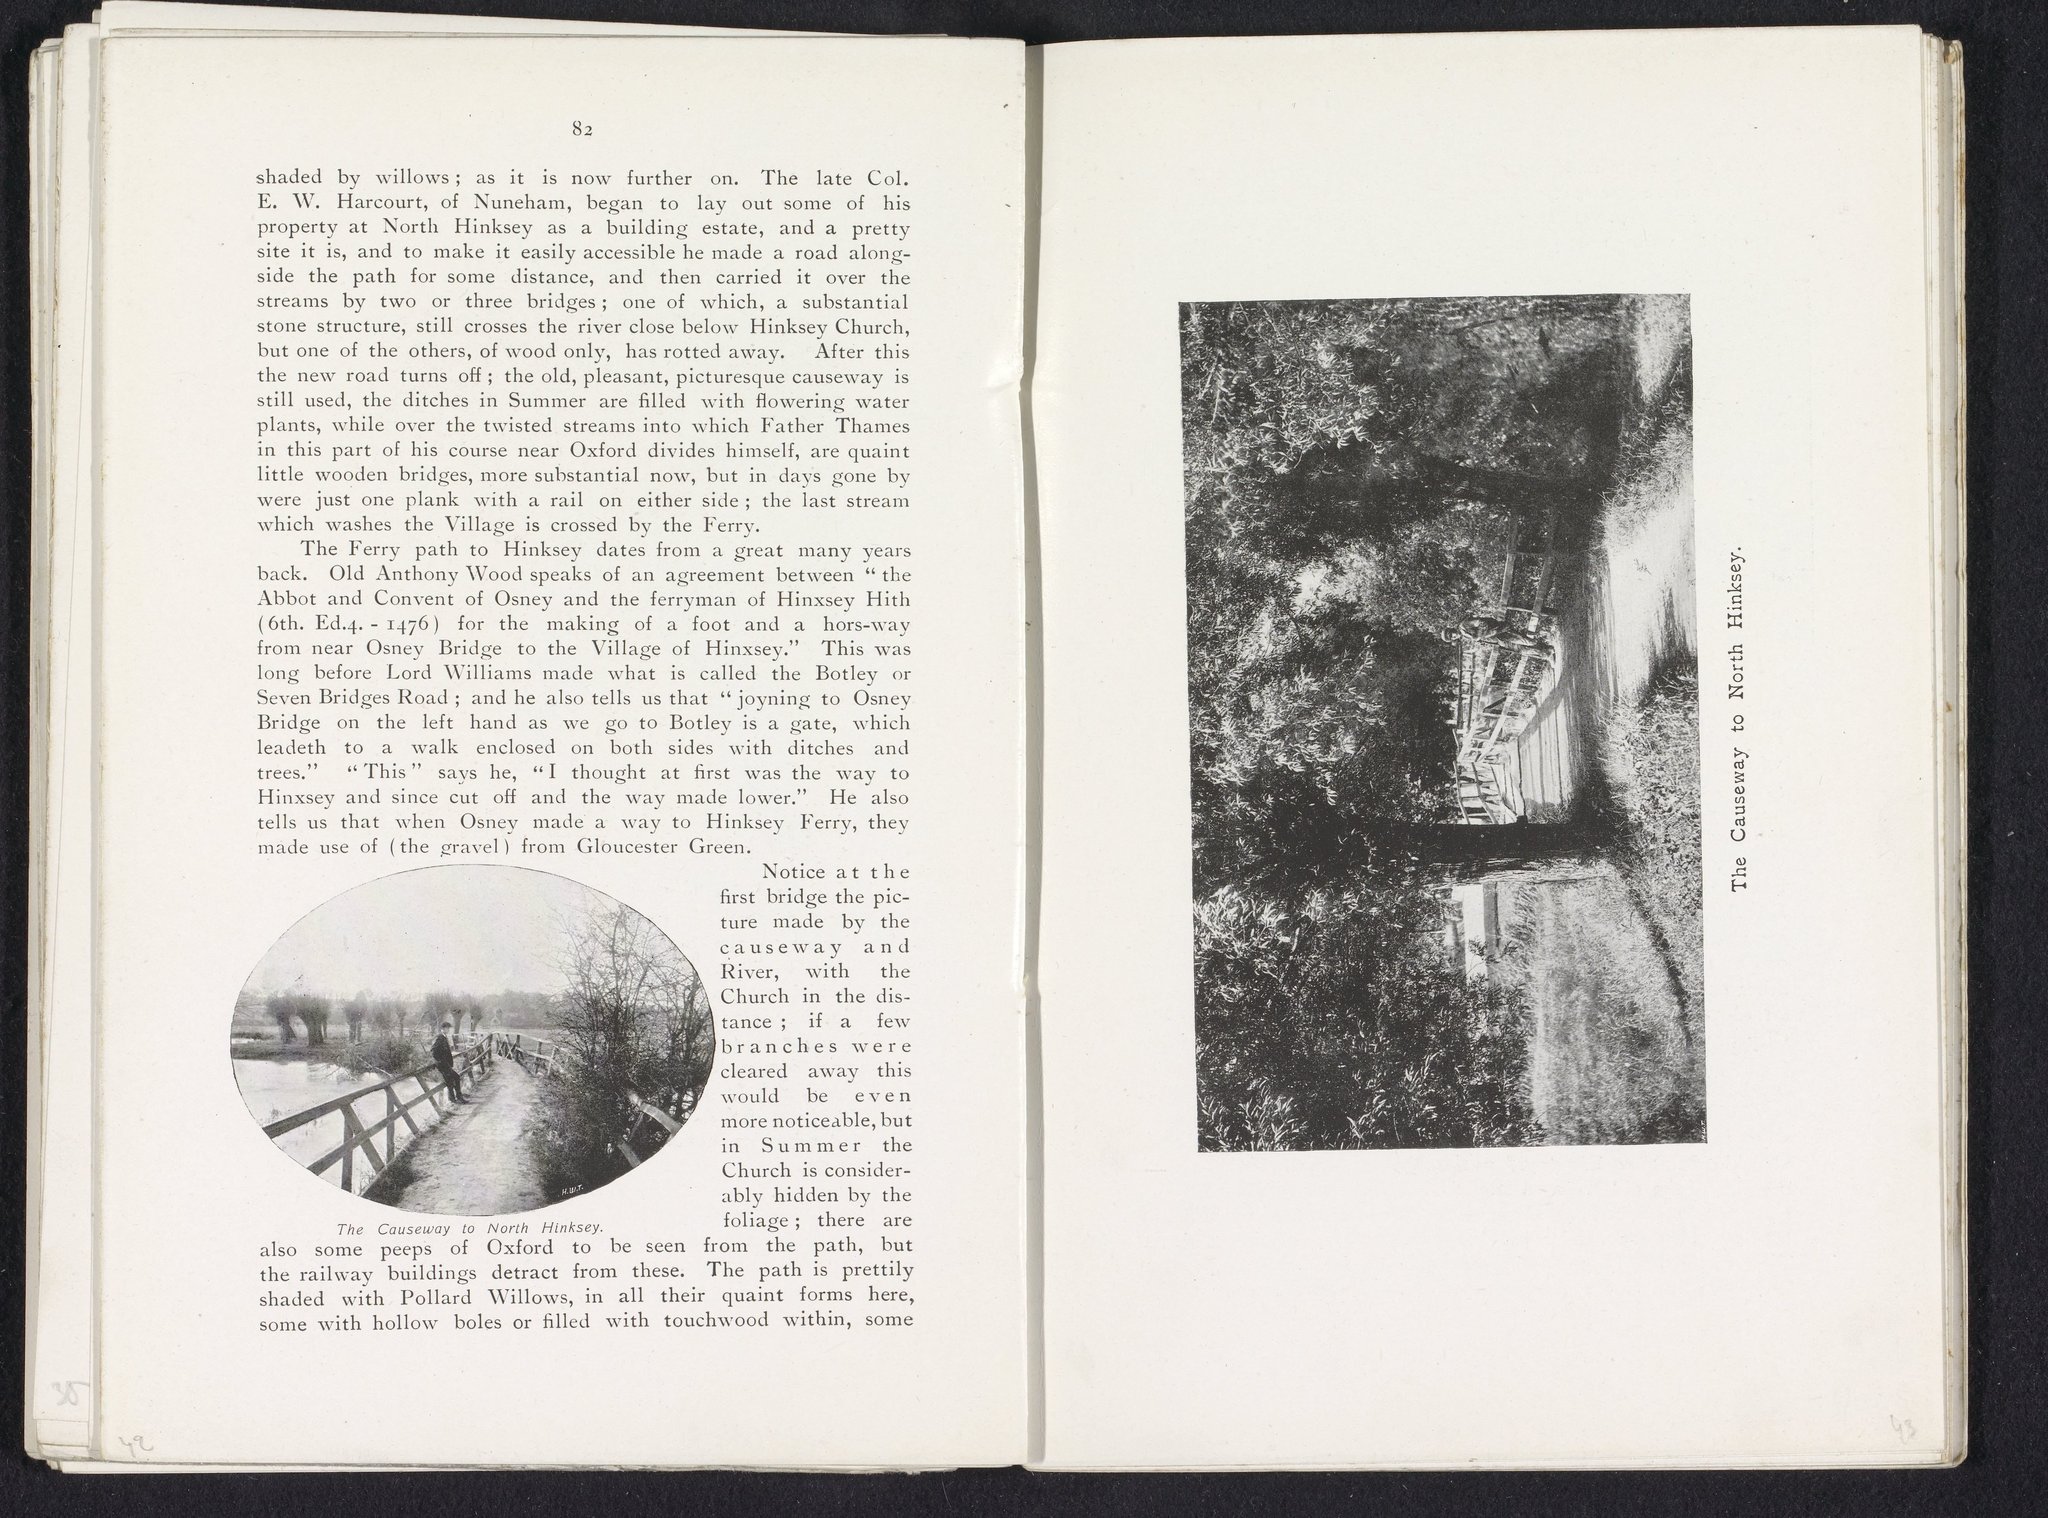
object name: page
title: The causeway to North Hinksey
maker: henry w. taunt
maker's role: fotograaf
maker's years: 1842-1922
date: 1907-1912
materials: paper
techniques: autotype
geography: oxfordshire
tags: adult man, public road in village, bridge